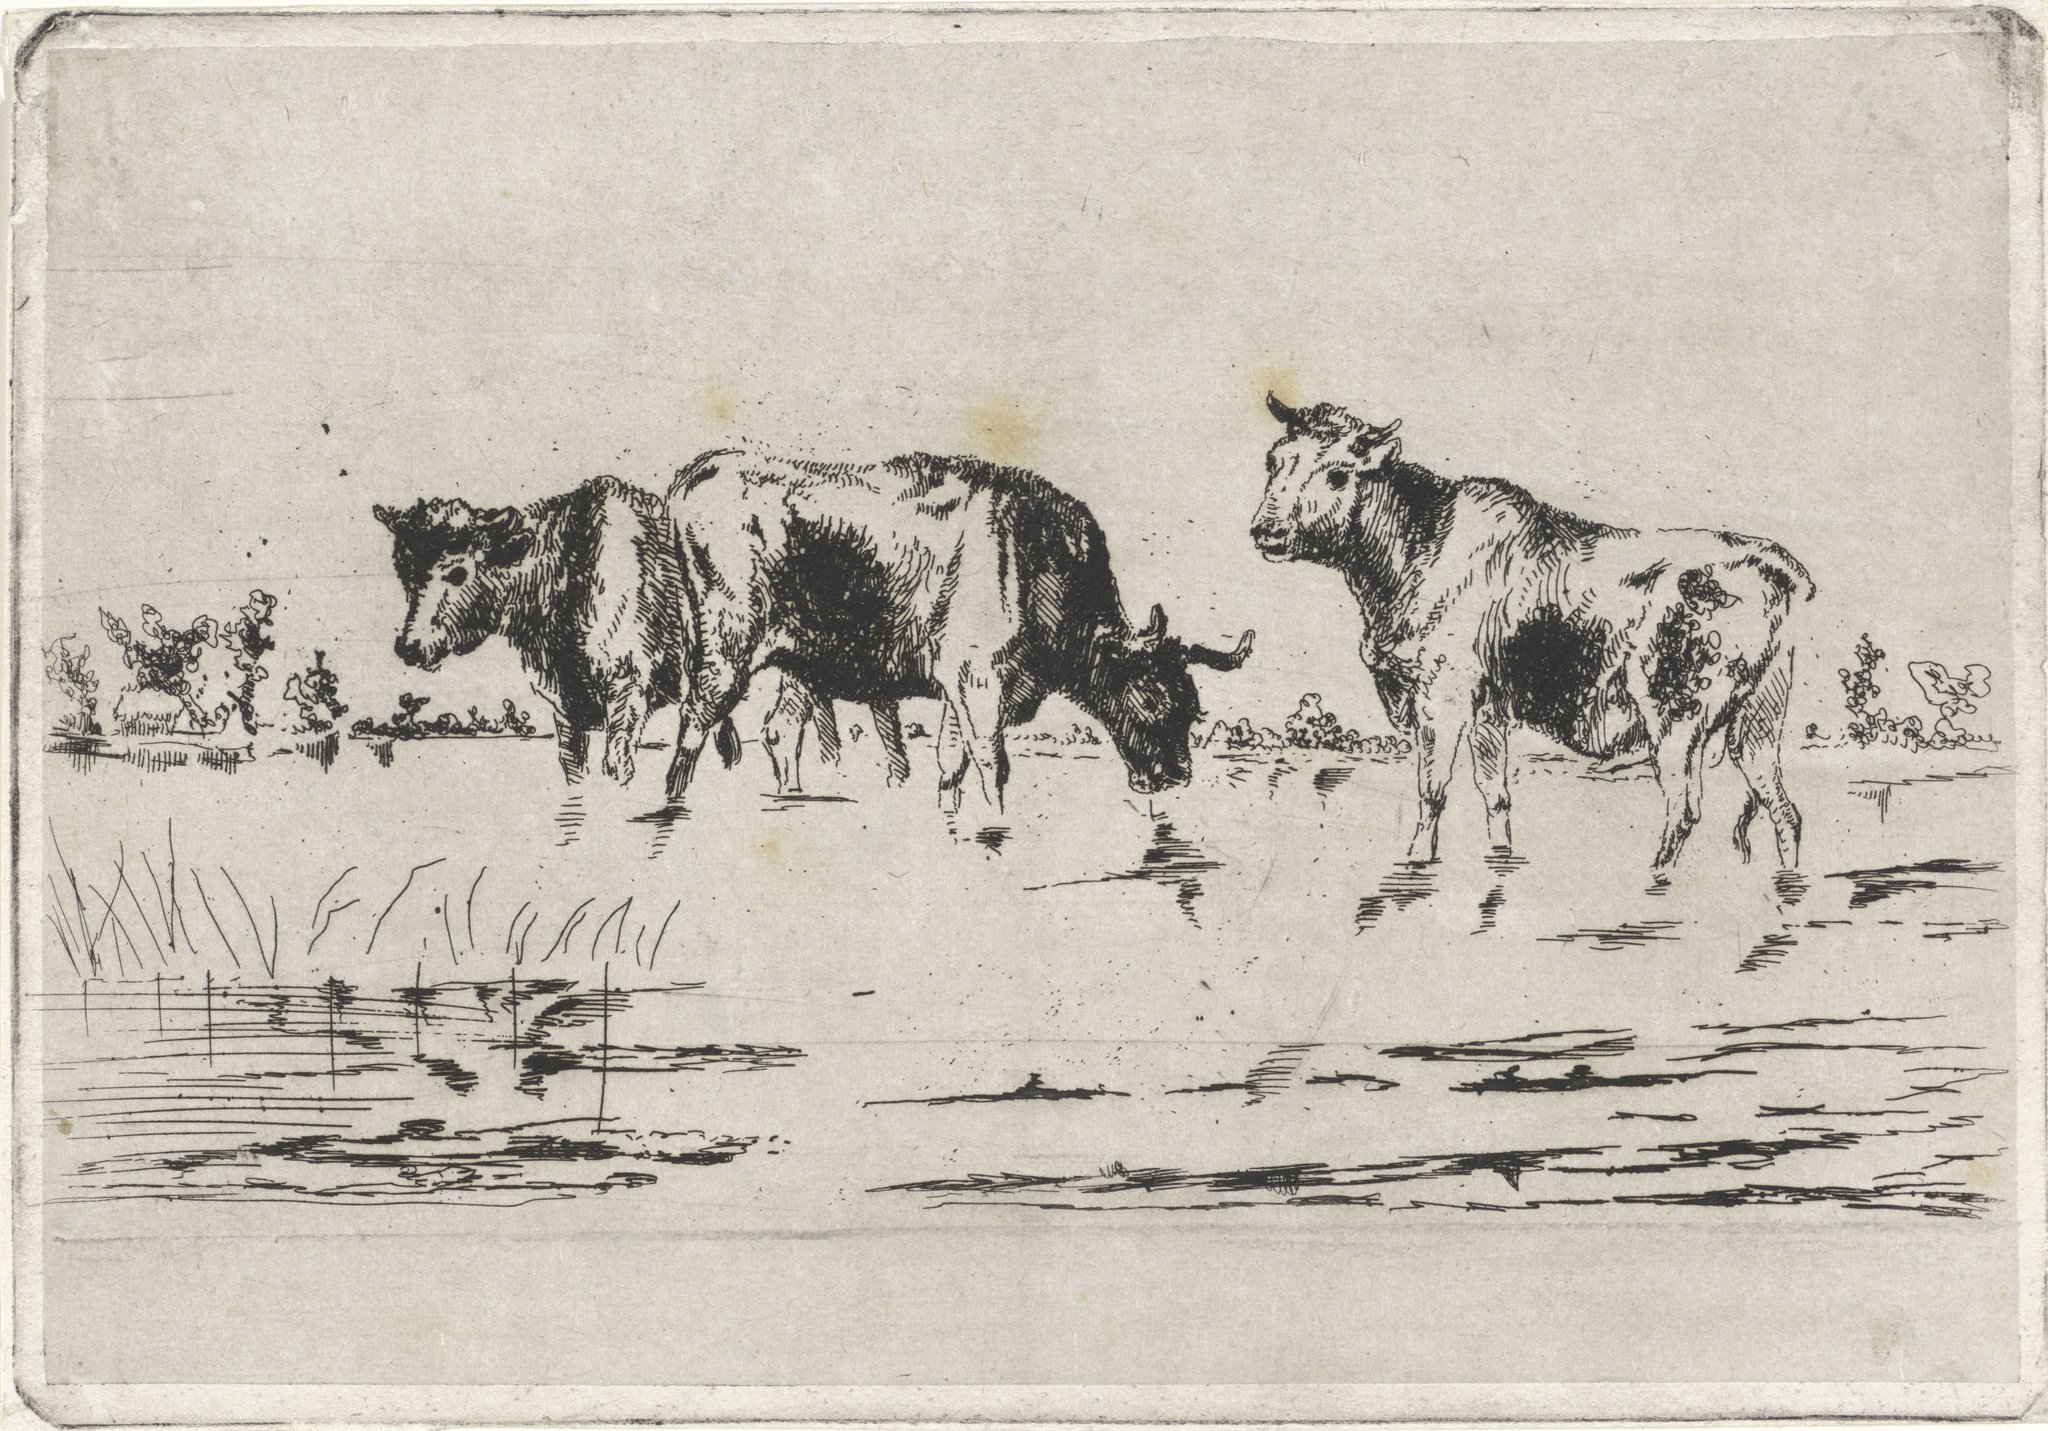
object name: print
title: Koeien in een ondergelopen weiland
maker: arnoud schaepkens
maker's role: print maker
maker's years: 1816-1904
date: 1831-1904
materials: paper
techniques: etching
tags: cow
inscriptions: collector's mark: Lugt 2228